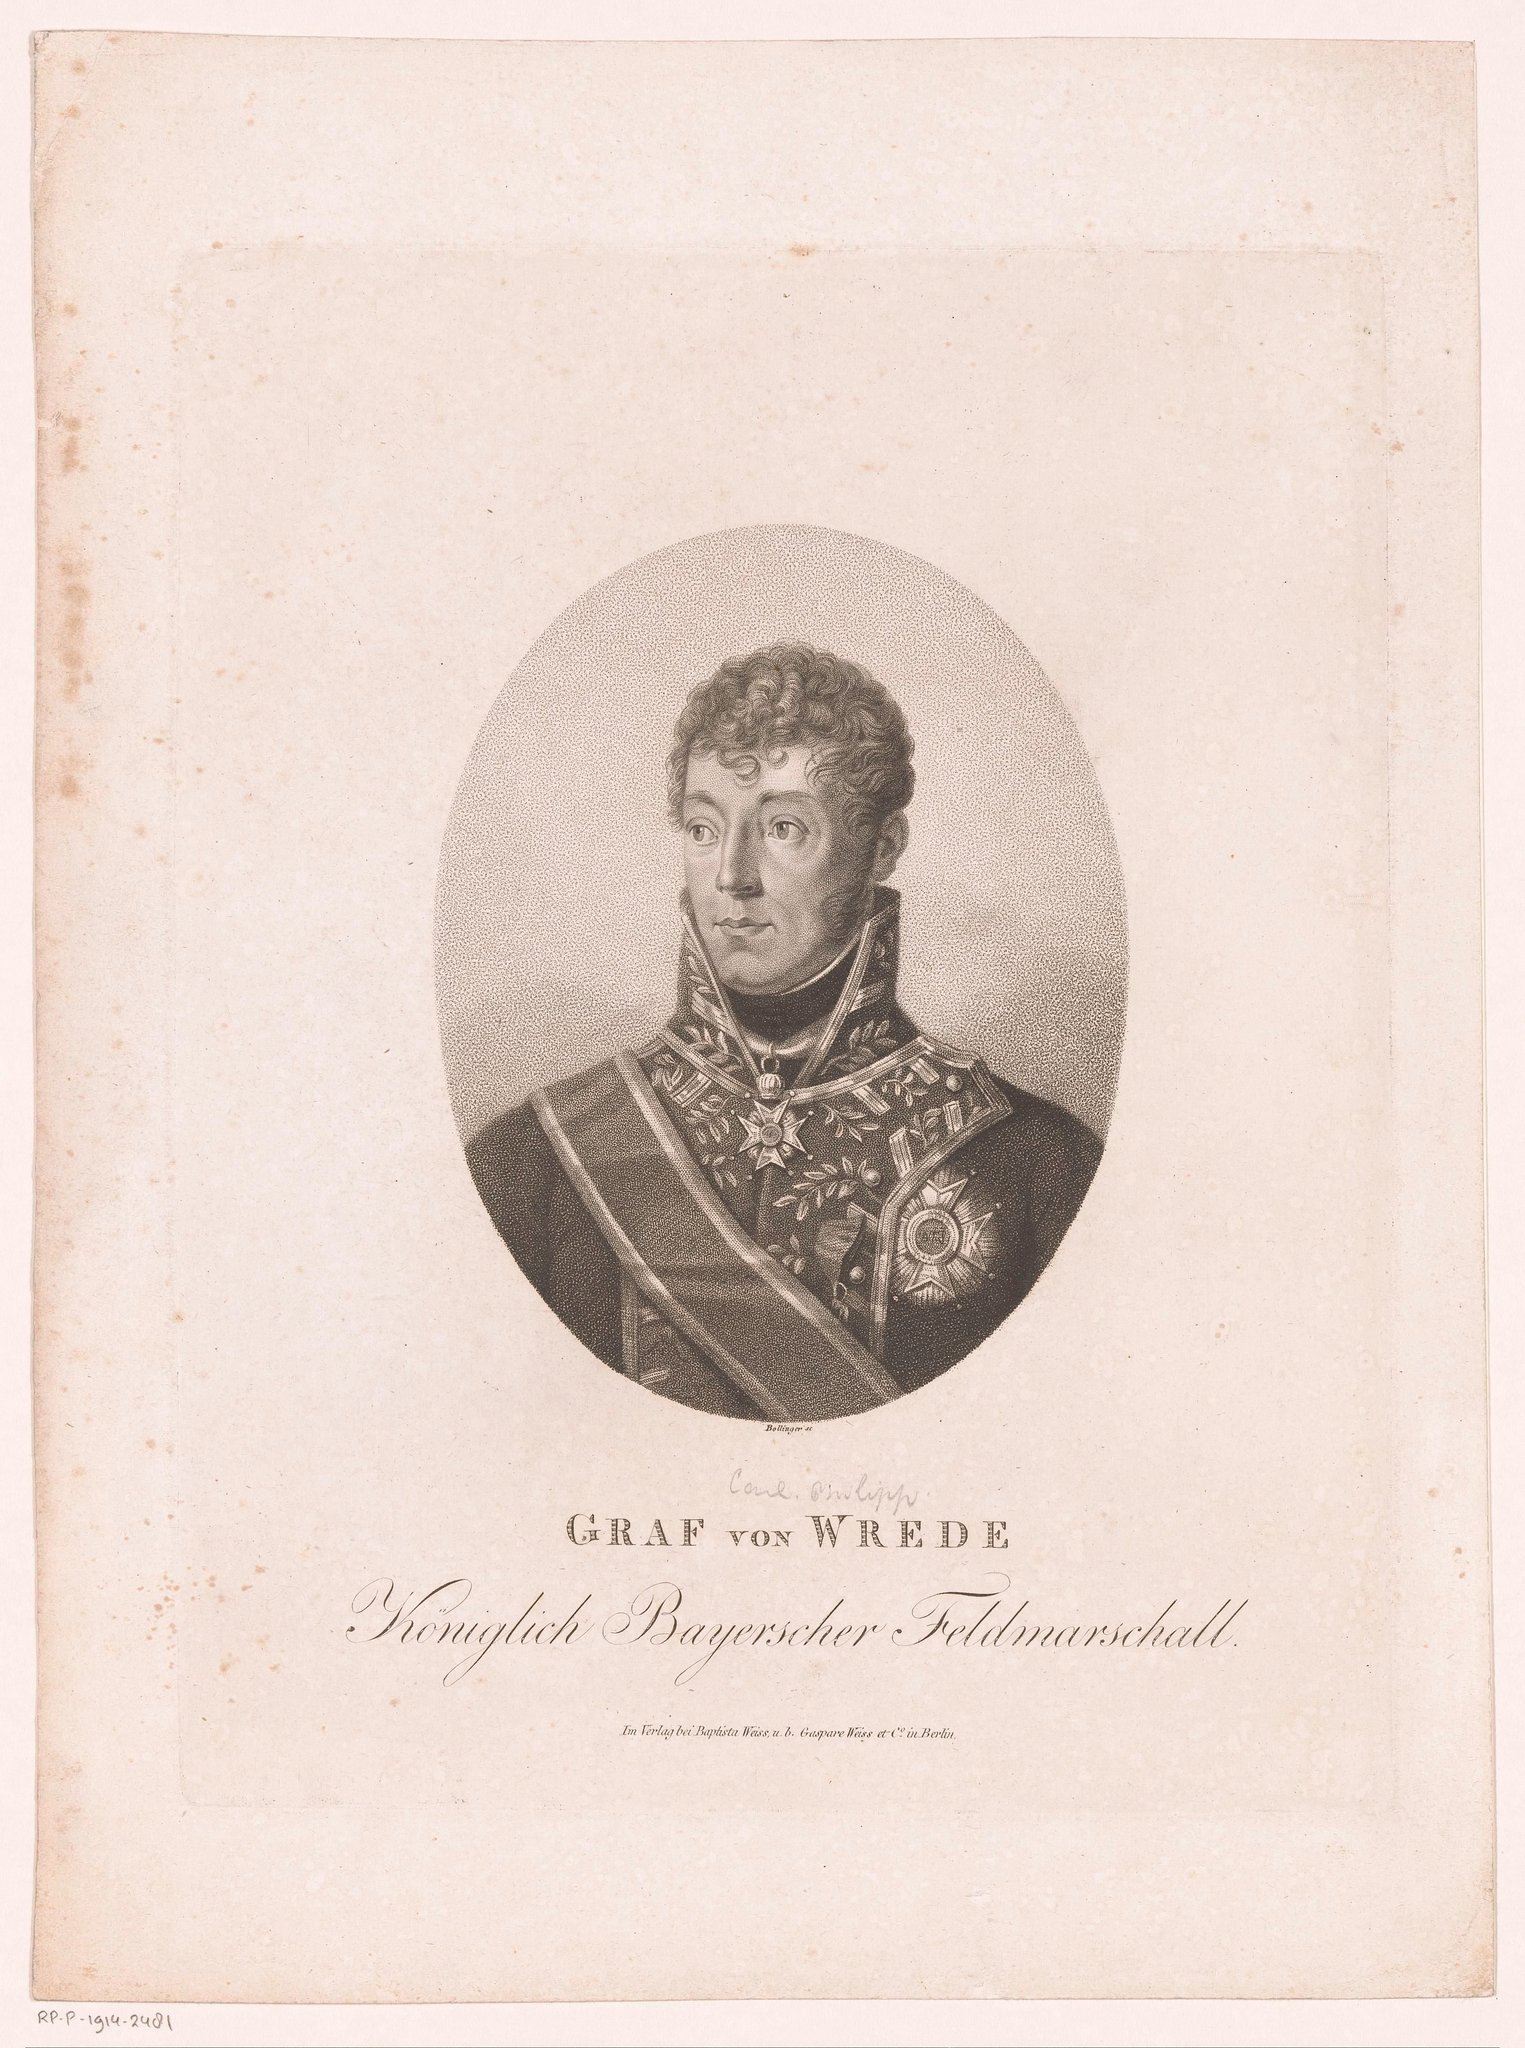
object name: print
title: Portret van Carl Philipp von Wrede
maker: friedrich wilhelm bollinger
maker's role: print maker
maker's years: 1777-1825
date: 1814-1825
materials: paper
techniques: stippling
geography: berlin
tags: knighthood order, historical persons, (military) uniforms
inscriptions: collector's mark: Lugt 2228